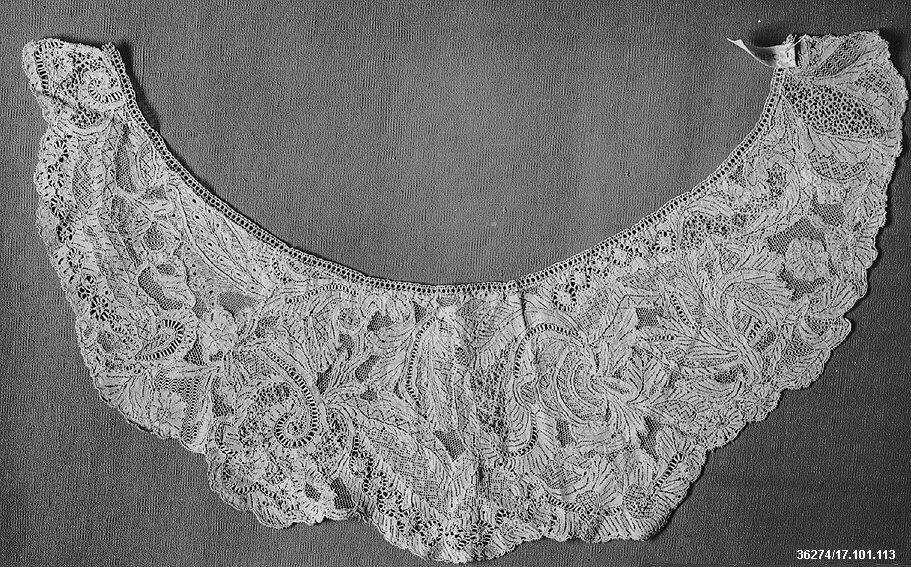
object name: sleeve piece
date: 1701-1800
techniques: lace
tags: flowers,leaves